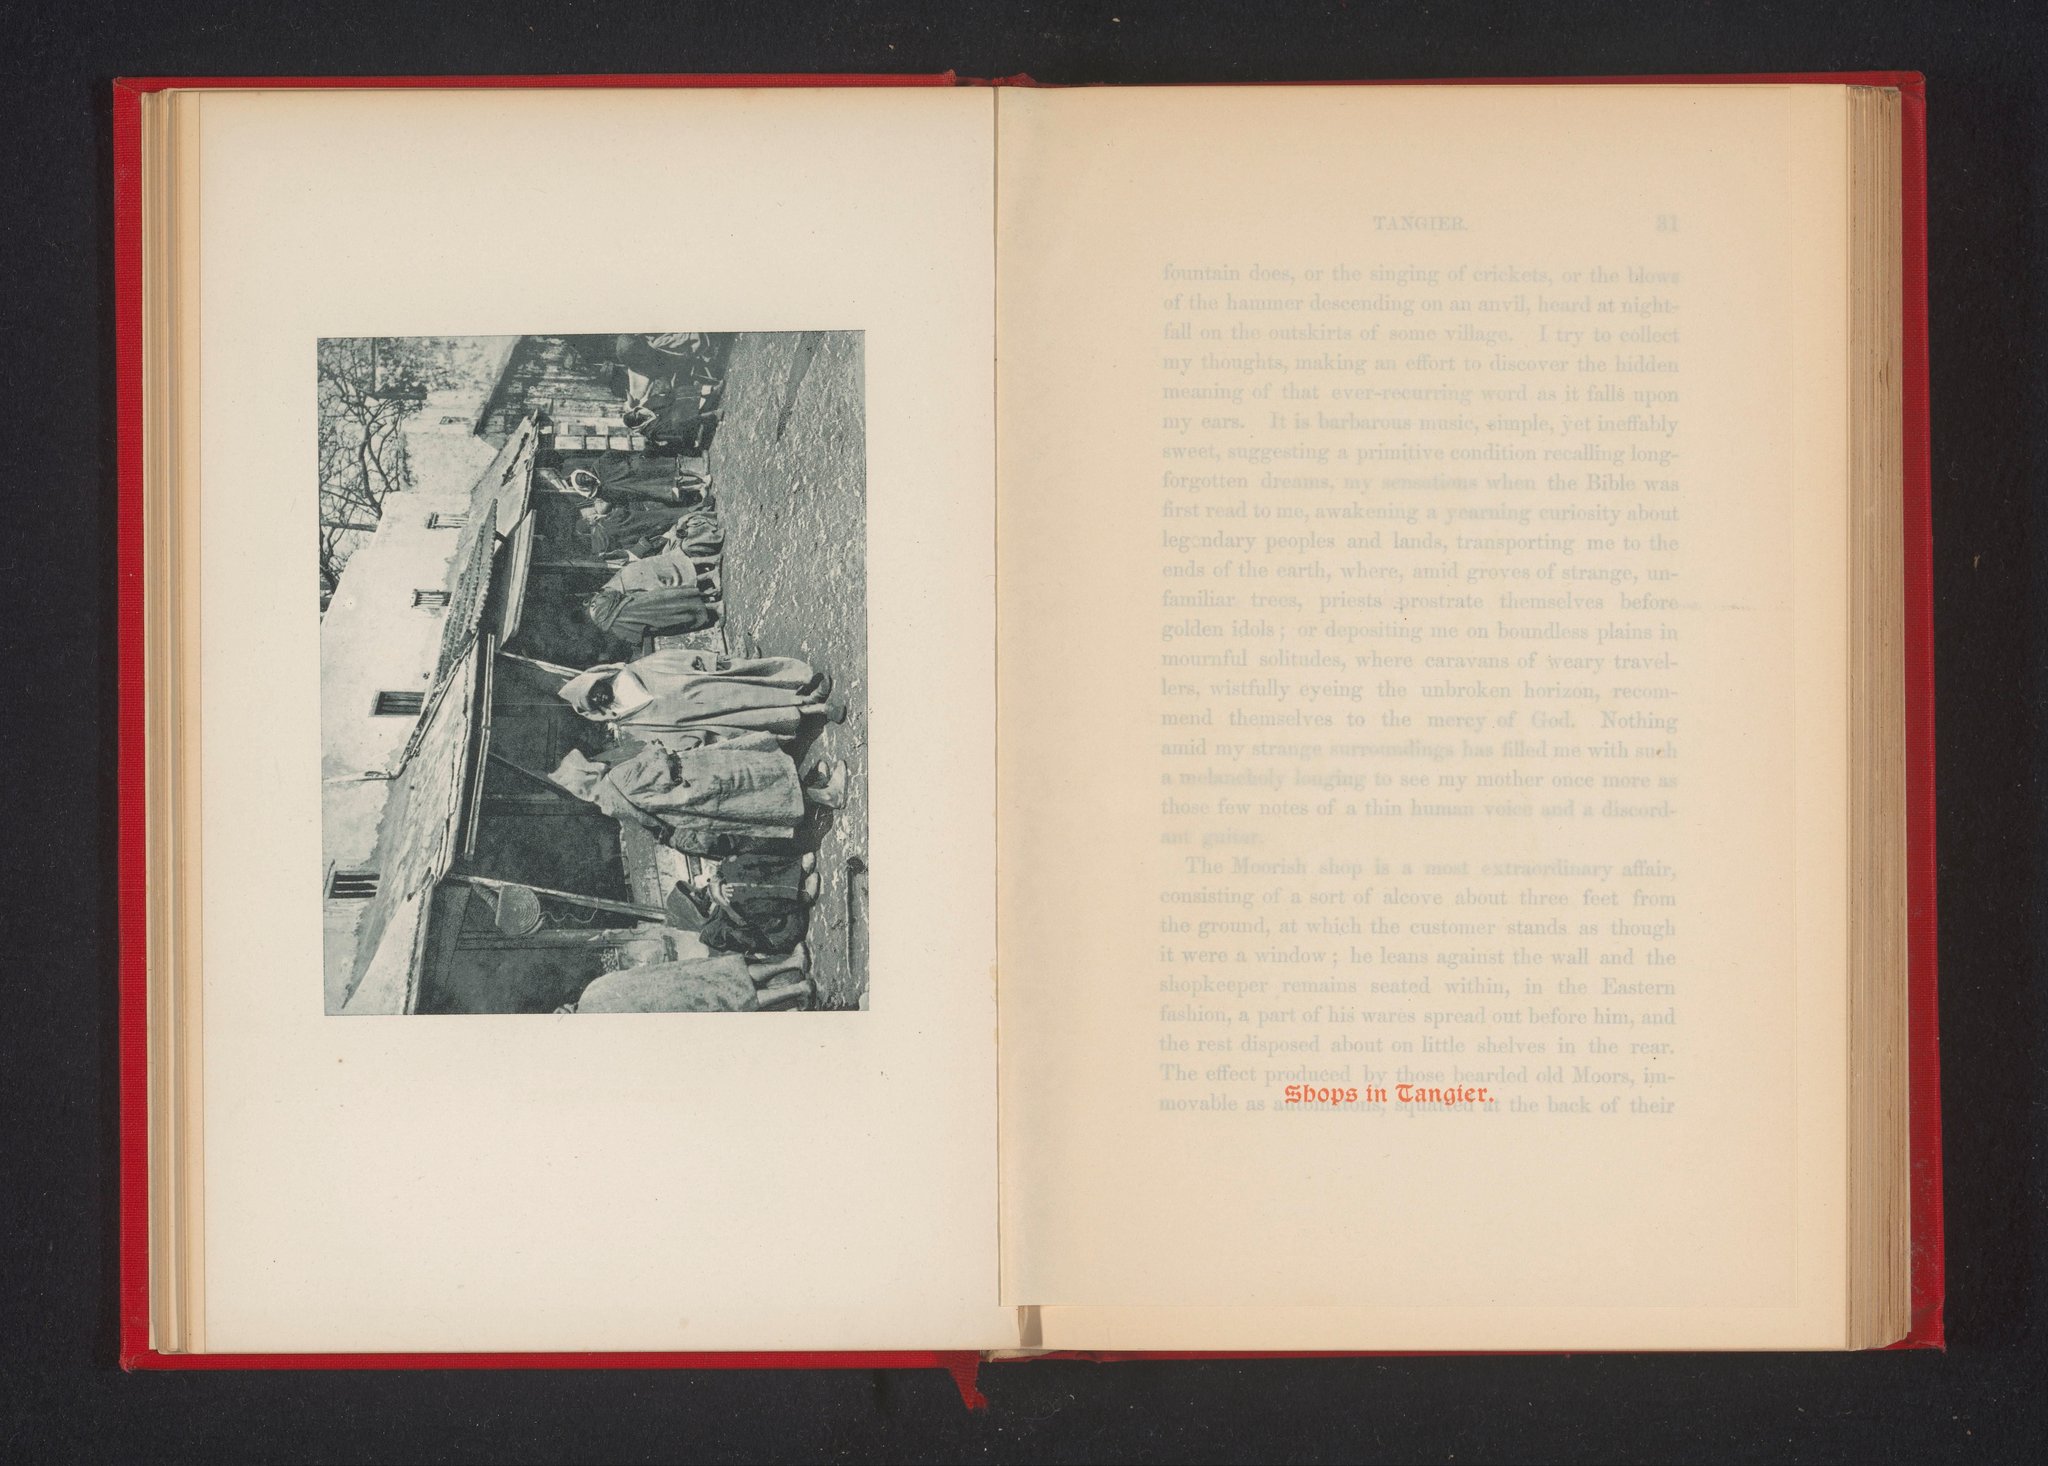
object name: photomechanical print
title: Winkels in een straat te Tanger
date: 1887-1897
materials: paper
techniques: photoaquatint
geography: tanger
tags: shop, store, street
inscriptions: title: ‘Shops in Tangier.’